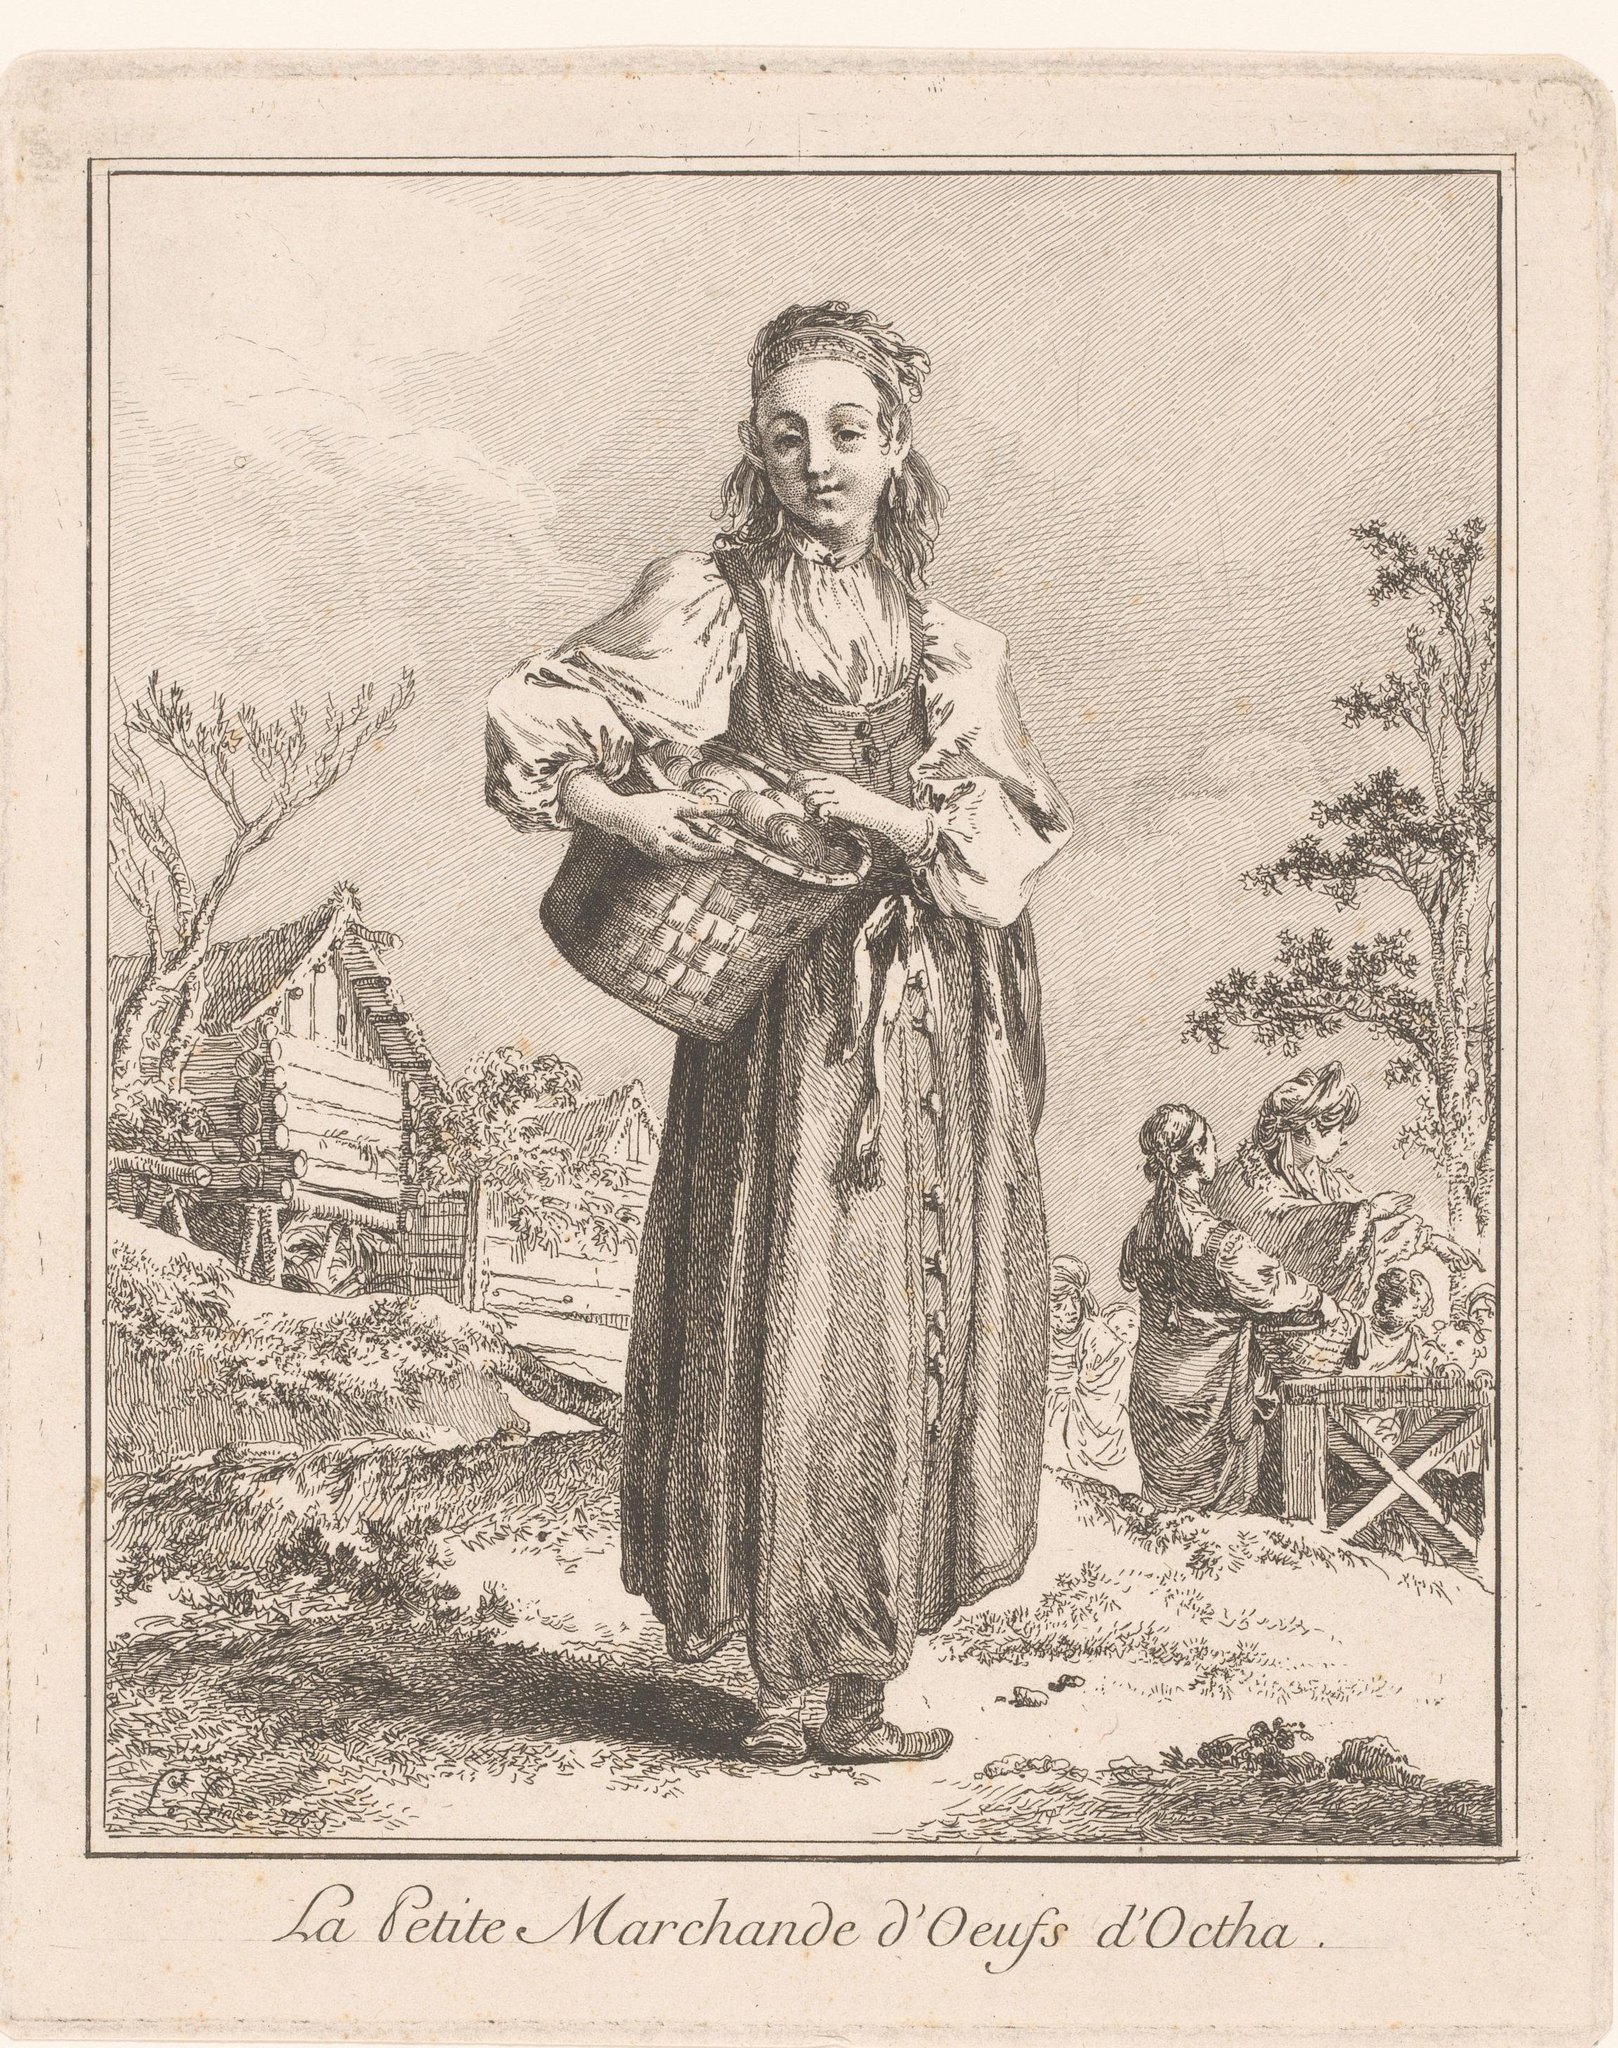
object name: print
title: Premiere Suite de Cris et Divers Marchands de Petersbourg et de Moscou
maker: jean baptist leprince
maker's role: draughtsman, print maker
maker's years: 1734-1781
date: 1765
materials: paper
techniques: etching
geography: france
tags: container made of plant material other than wood: basket, merchant, salesman - bb - women engaged in trade and commerce, eggs, egg-dishes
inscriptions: collector's mark: Lugt 2228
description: Maakt deel uit van een zesdelige serie met handelaren en straatverkopers uit Sint-Petersburg en Moskou.